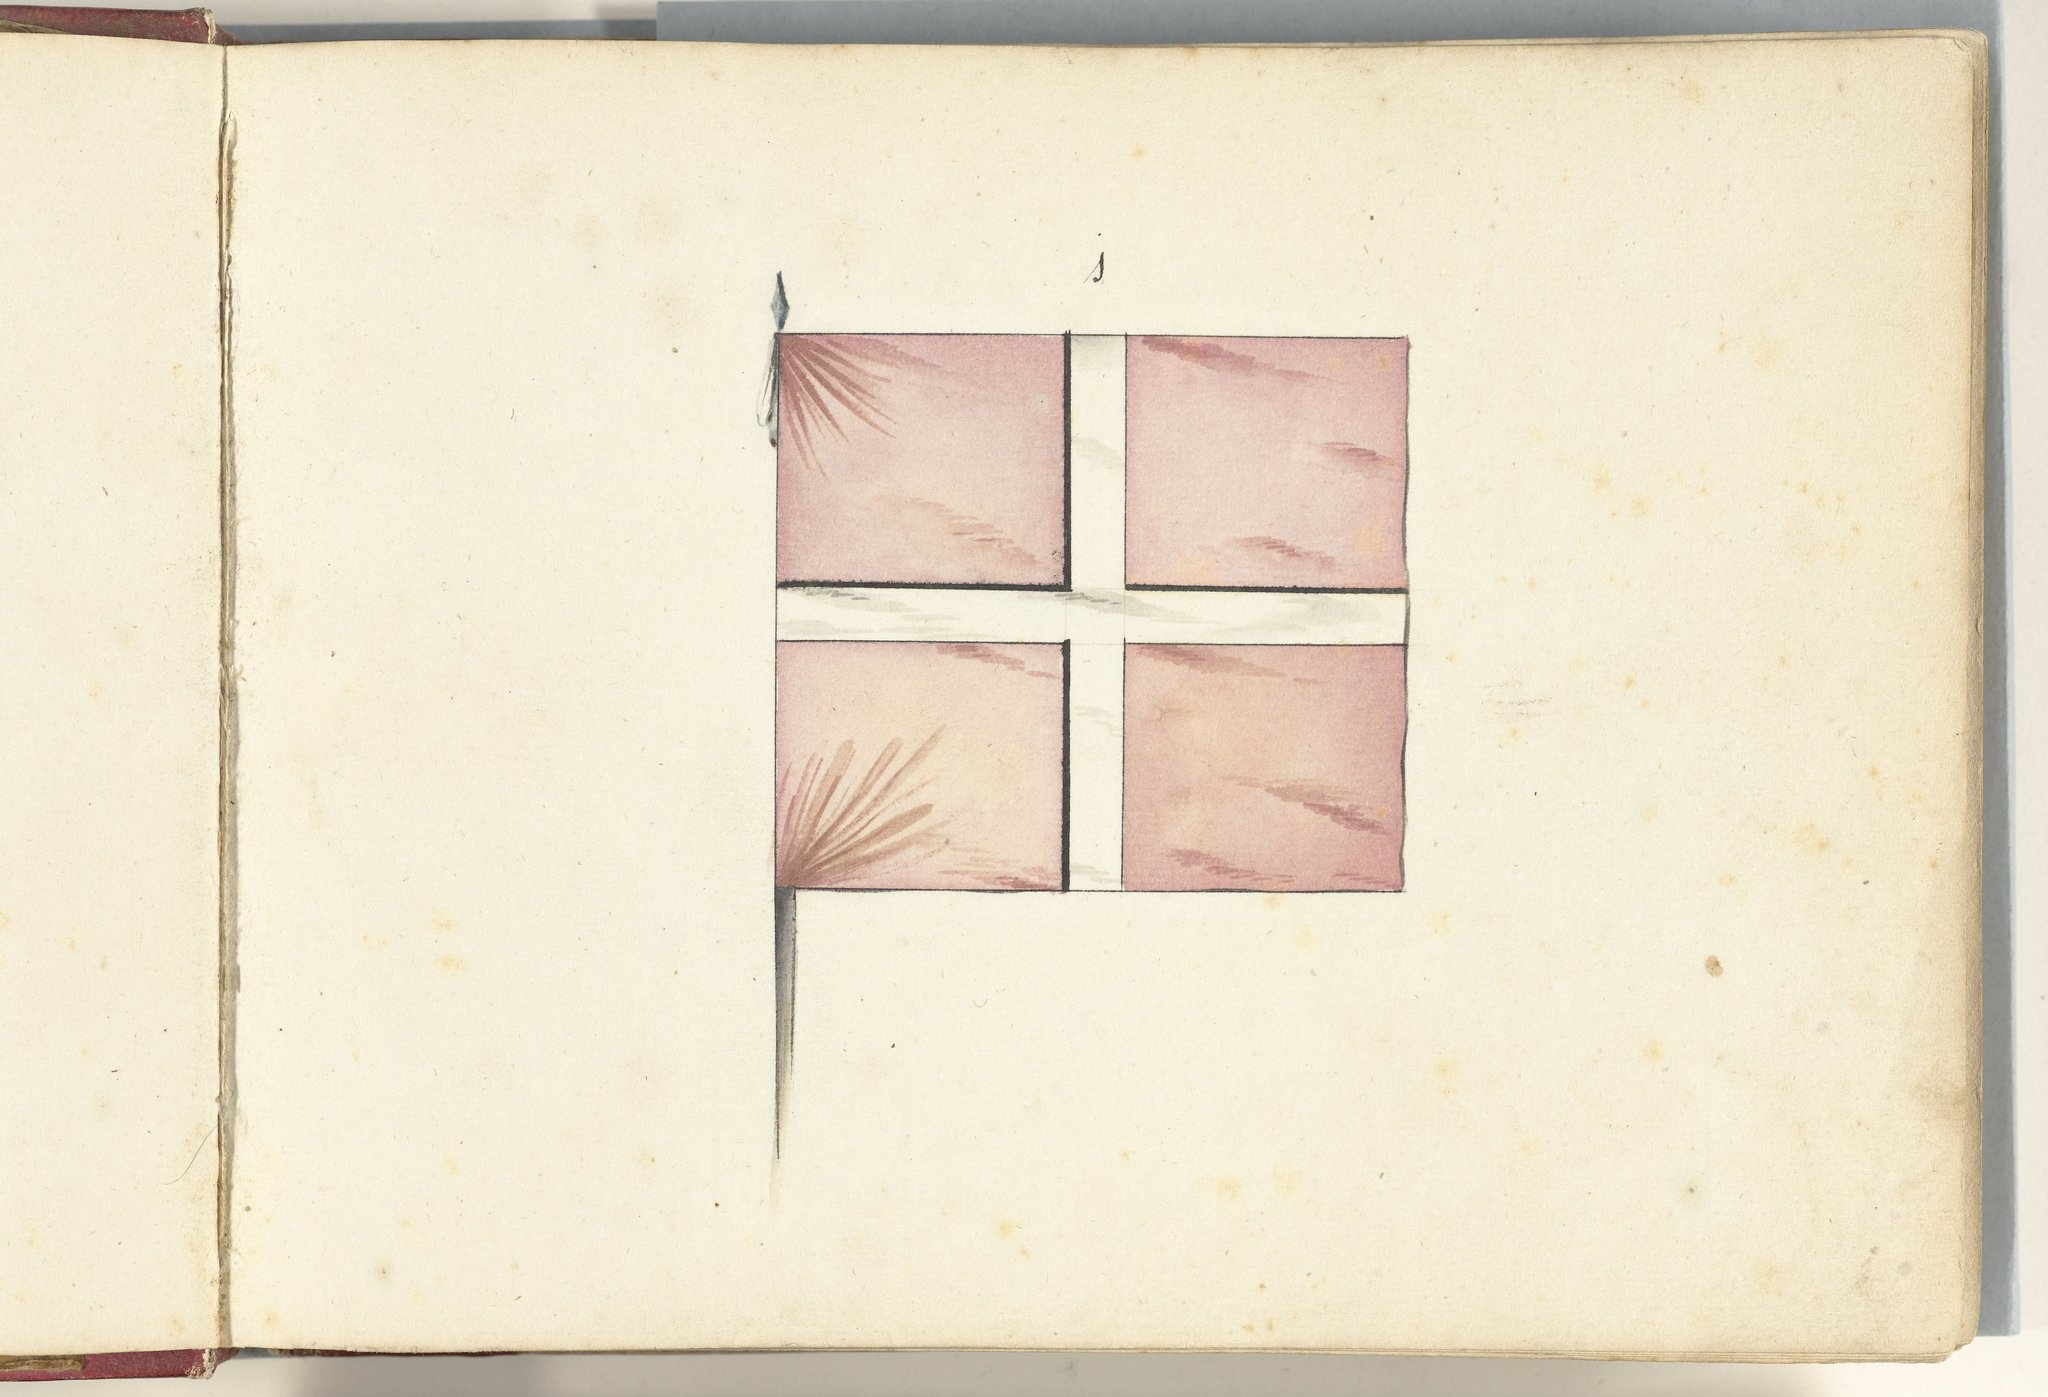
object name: drawing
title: Frans vaandel veroverd in de slag bij Spierbach, 1703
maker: Anonymous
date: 1713-1720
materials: paper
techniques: drawing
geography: northern netherlands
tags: (military) flags and standards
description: Frans vaandel veroverd in de slag bij Spierbach, 1703. In het boek met tekeningen van Franse vaandels, standaarden en pauken, veroverd tijdens de Spaanse Successieoorlog (1701-1713).